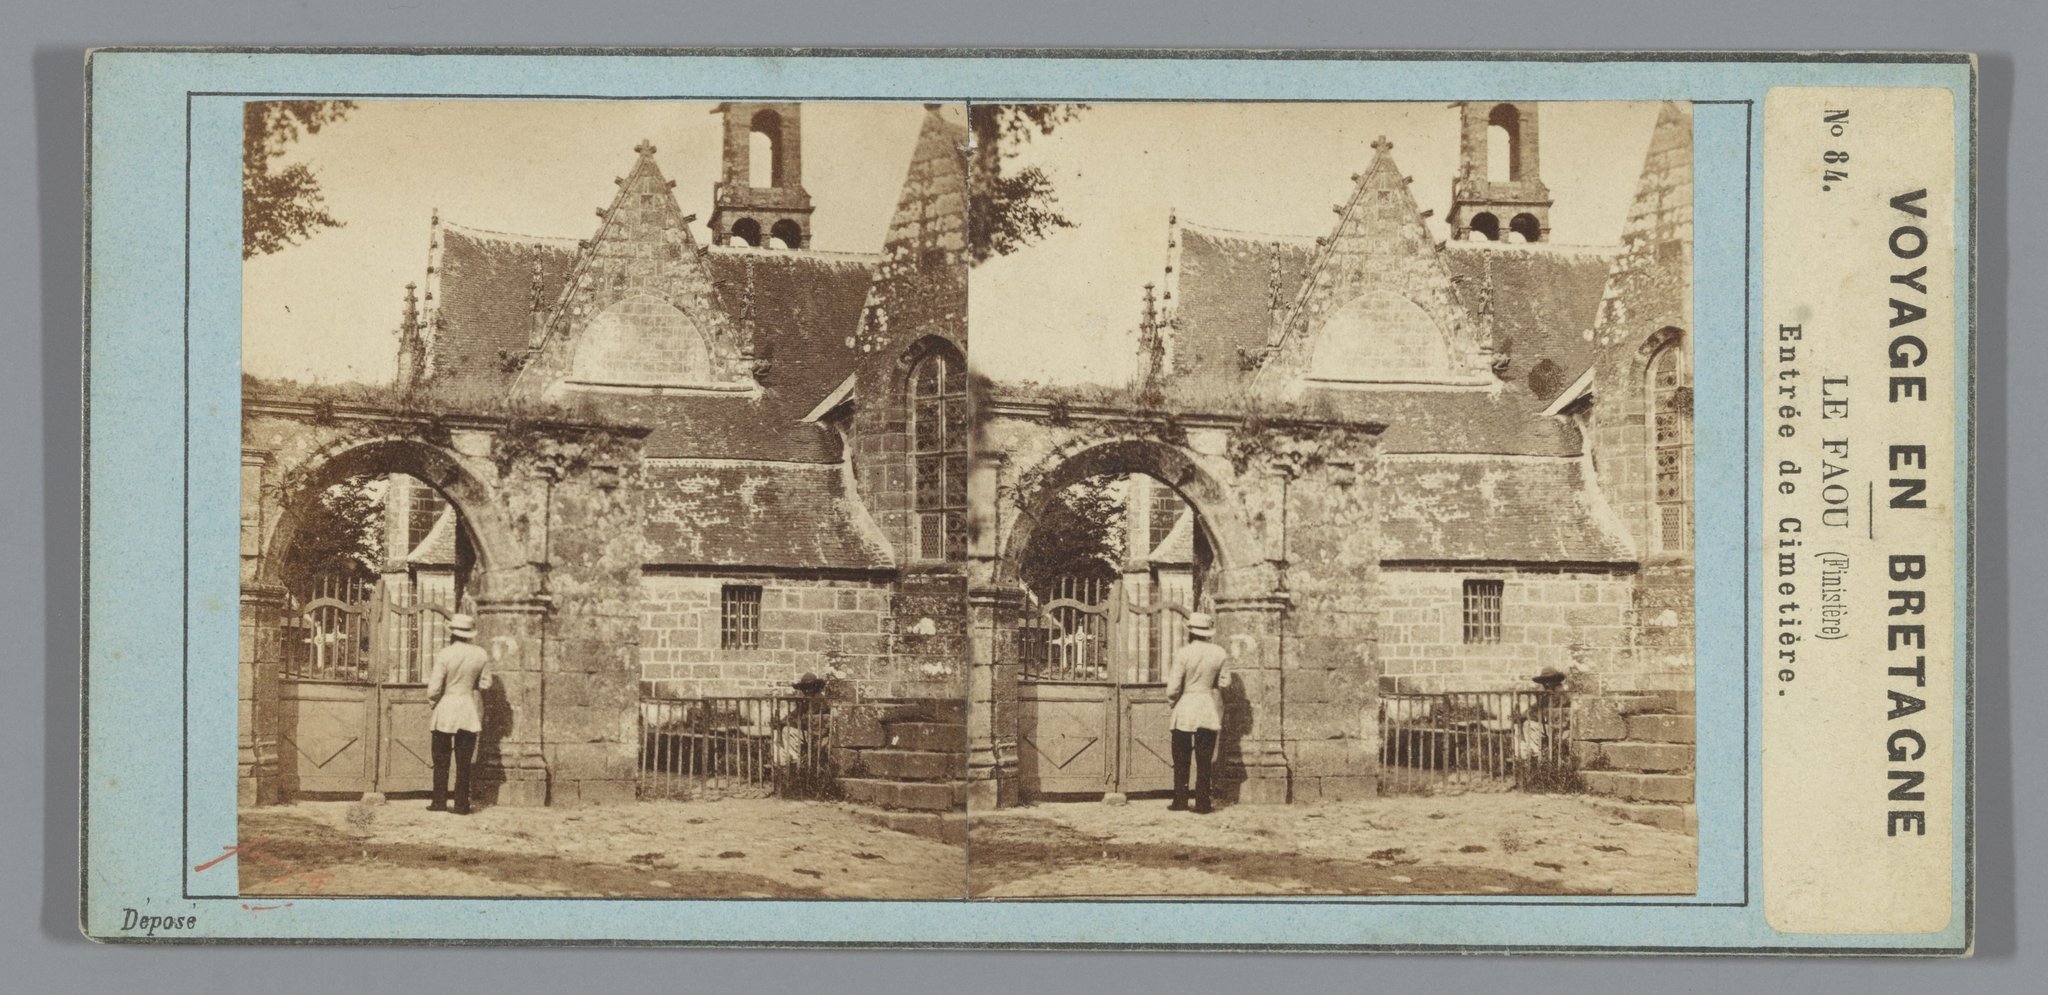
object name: stereograph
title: Toegang van de begraafplaats van Le Faou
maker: charles paul furne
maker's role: publisher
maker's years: 1824-1875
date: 1860-1870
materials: cardboard, photographic support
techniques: albumen print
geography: le faou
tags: gate, entrance, churchyard, cemetery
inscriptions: number: ‘No 84.’